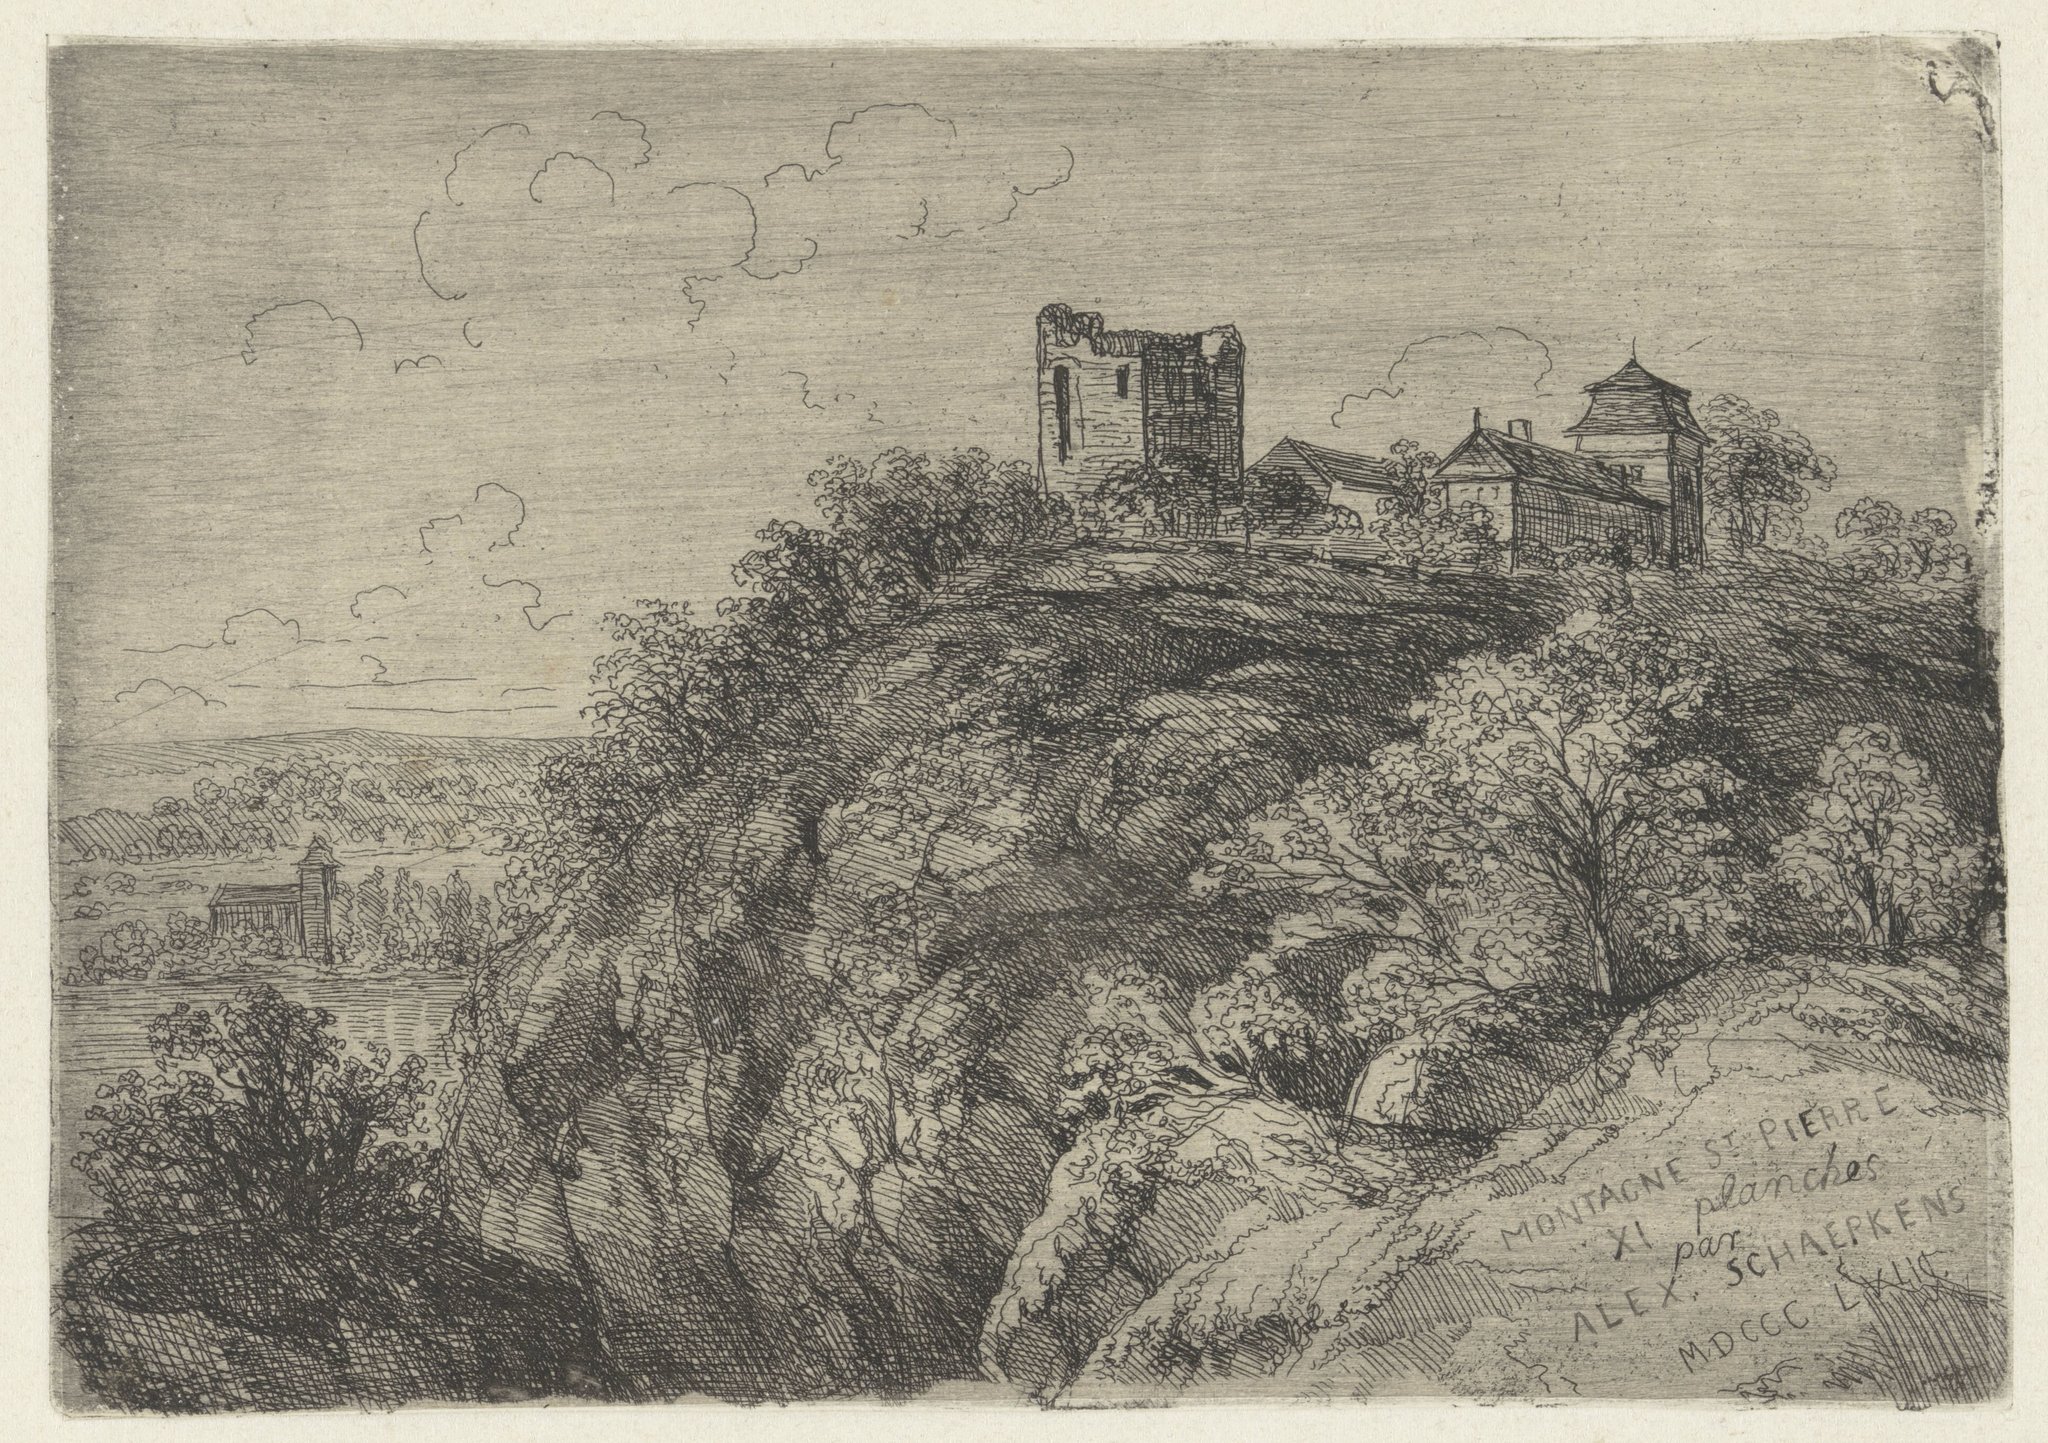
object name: print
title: Sint-Pietersberg met de ruïne van kasteel Lichtenberg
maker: alexander schaepkens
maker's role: draughtsman, print maker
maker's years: 1815-1899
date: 1858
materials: paper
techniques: etching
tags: low hill country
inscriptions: collector's mark: Lugt 2228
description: Zicht op de Sint-Pietersberg met de ruïne van kasteel Lichtenberg en de kasteelhoeve. Links aan de overzijde van de Maas de dorpskerk van Heugem.